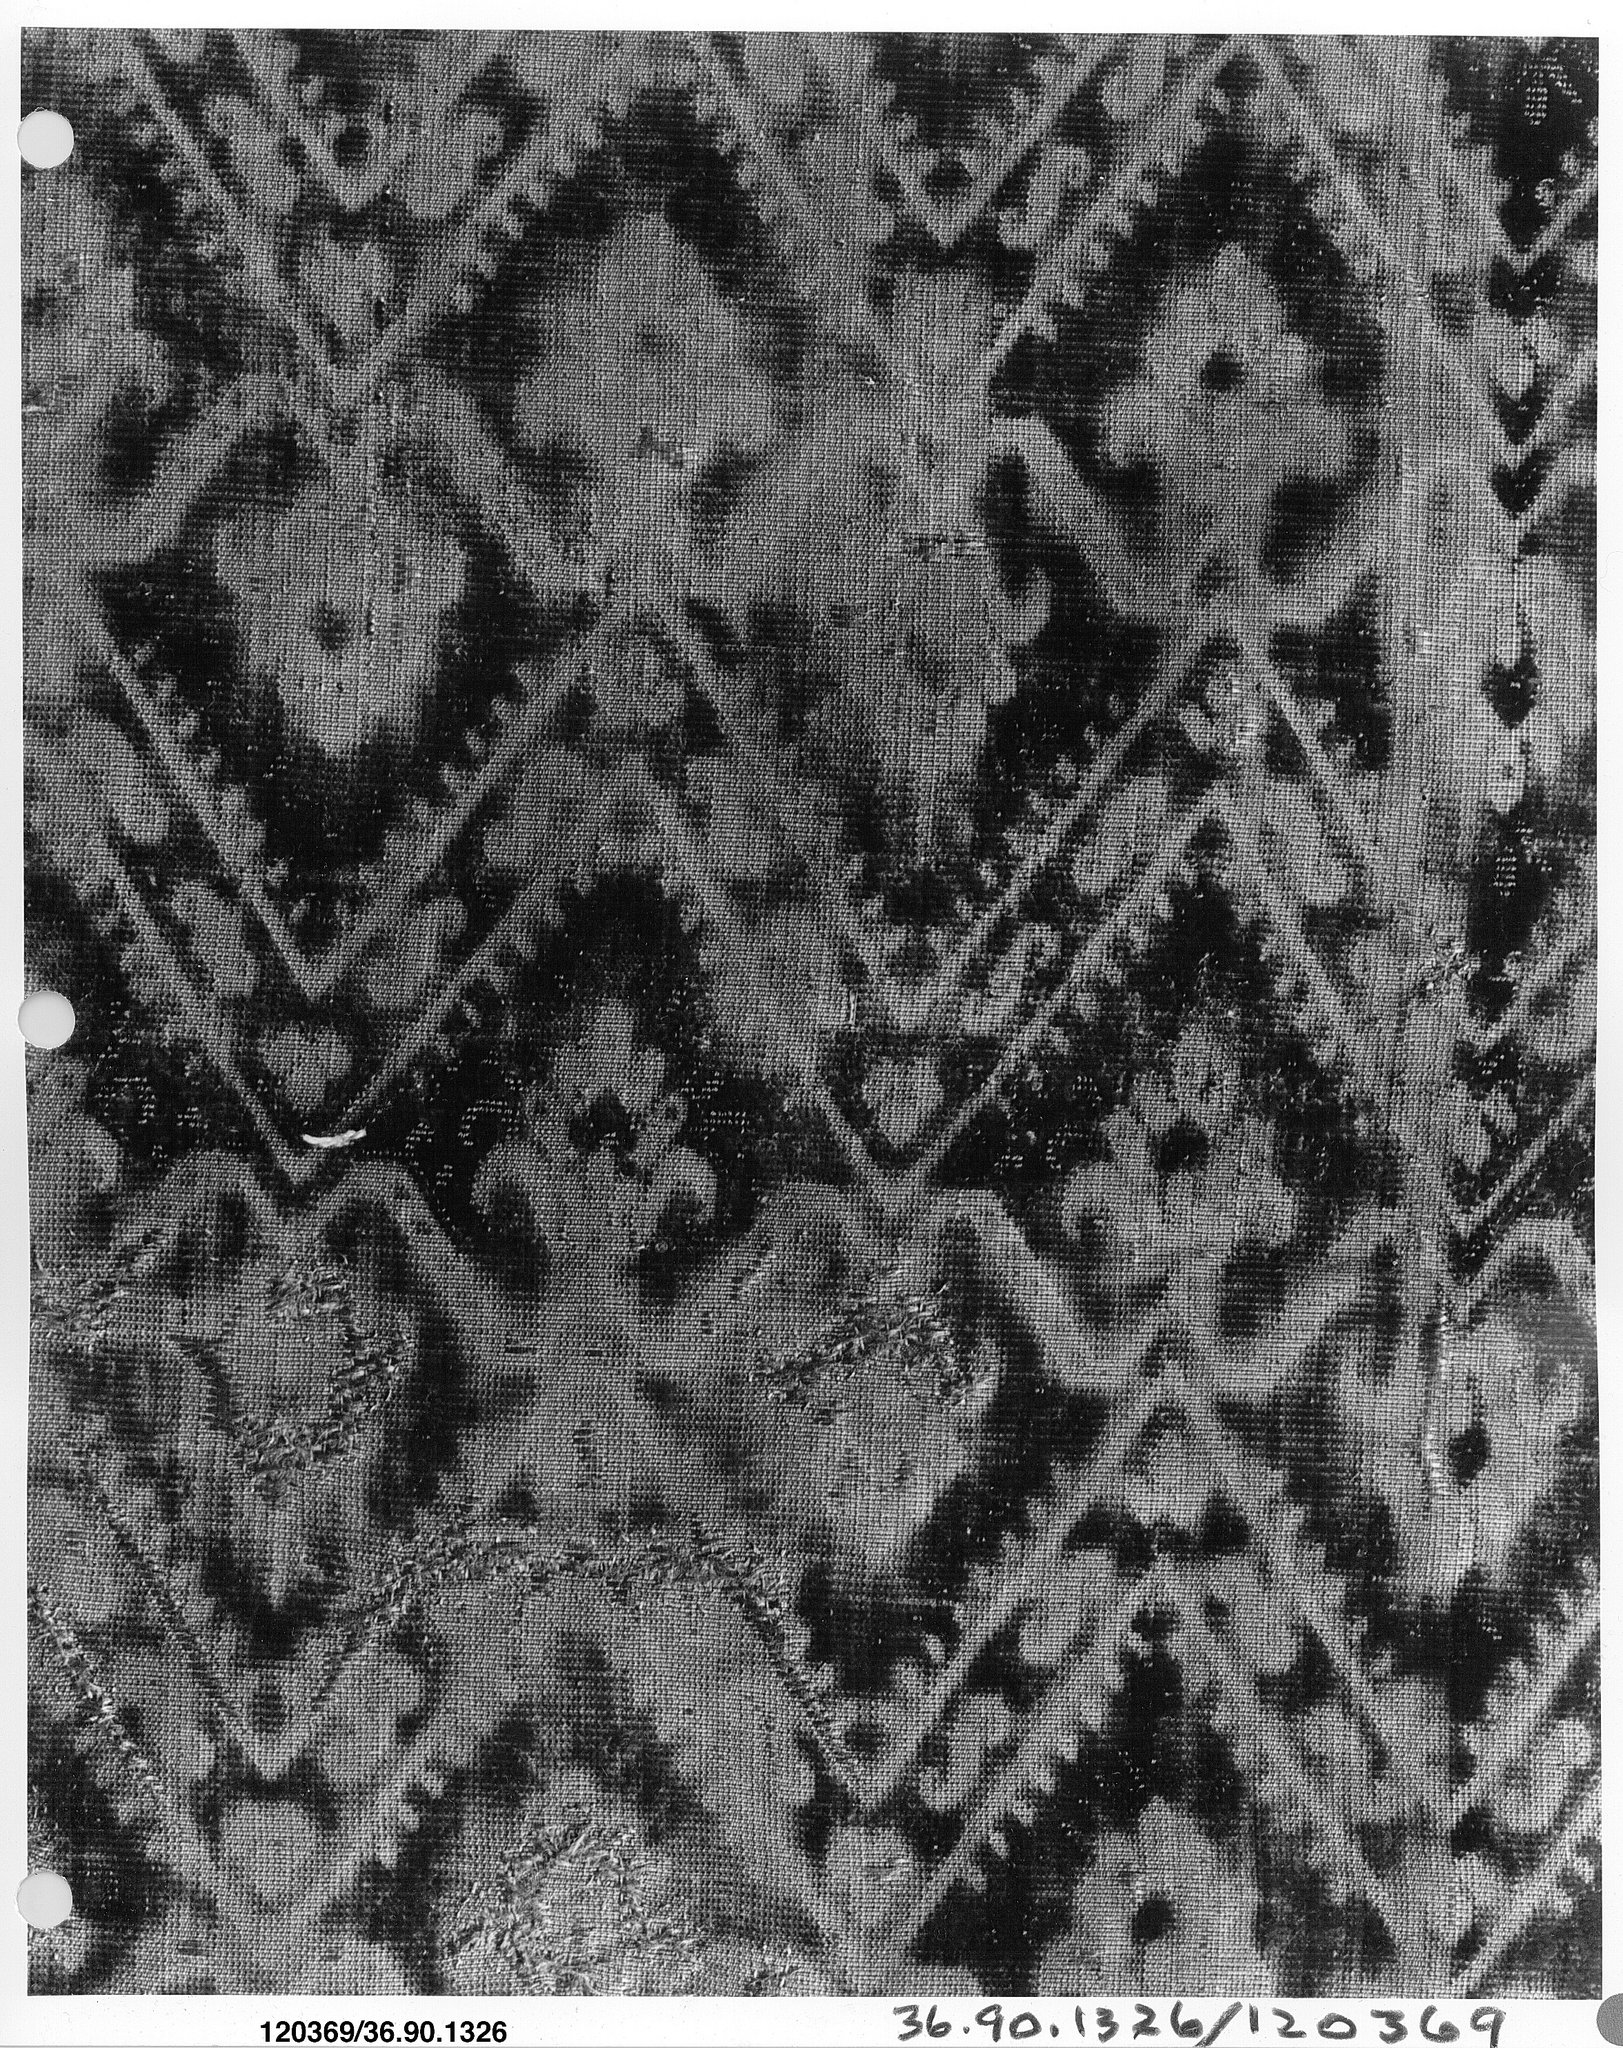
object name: piece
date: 1501-1700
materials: silk